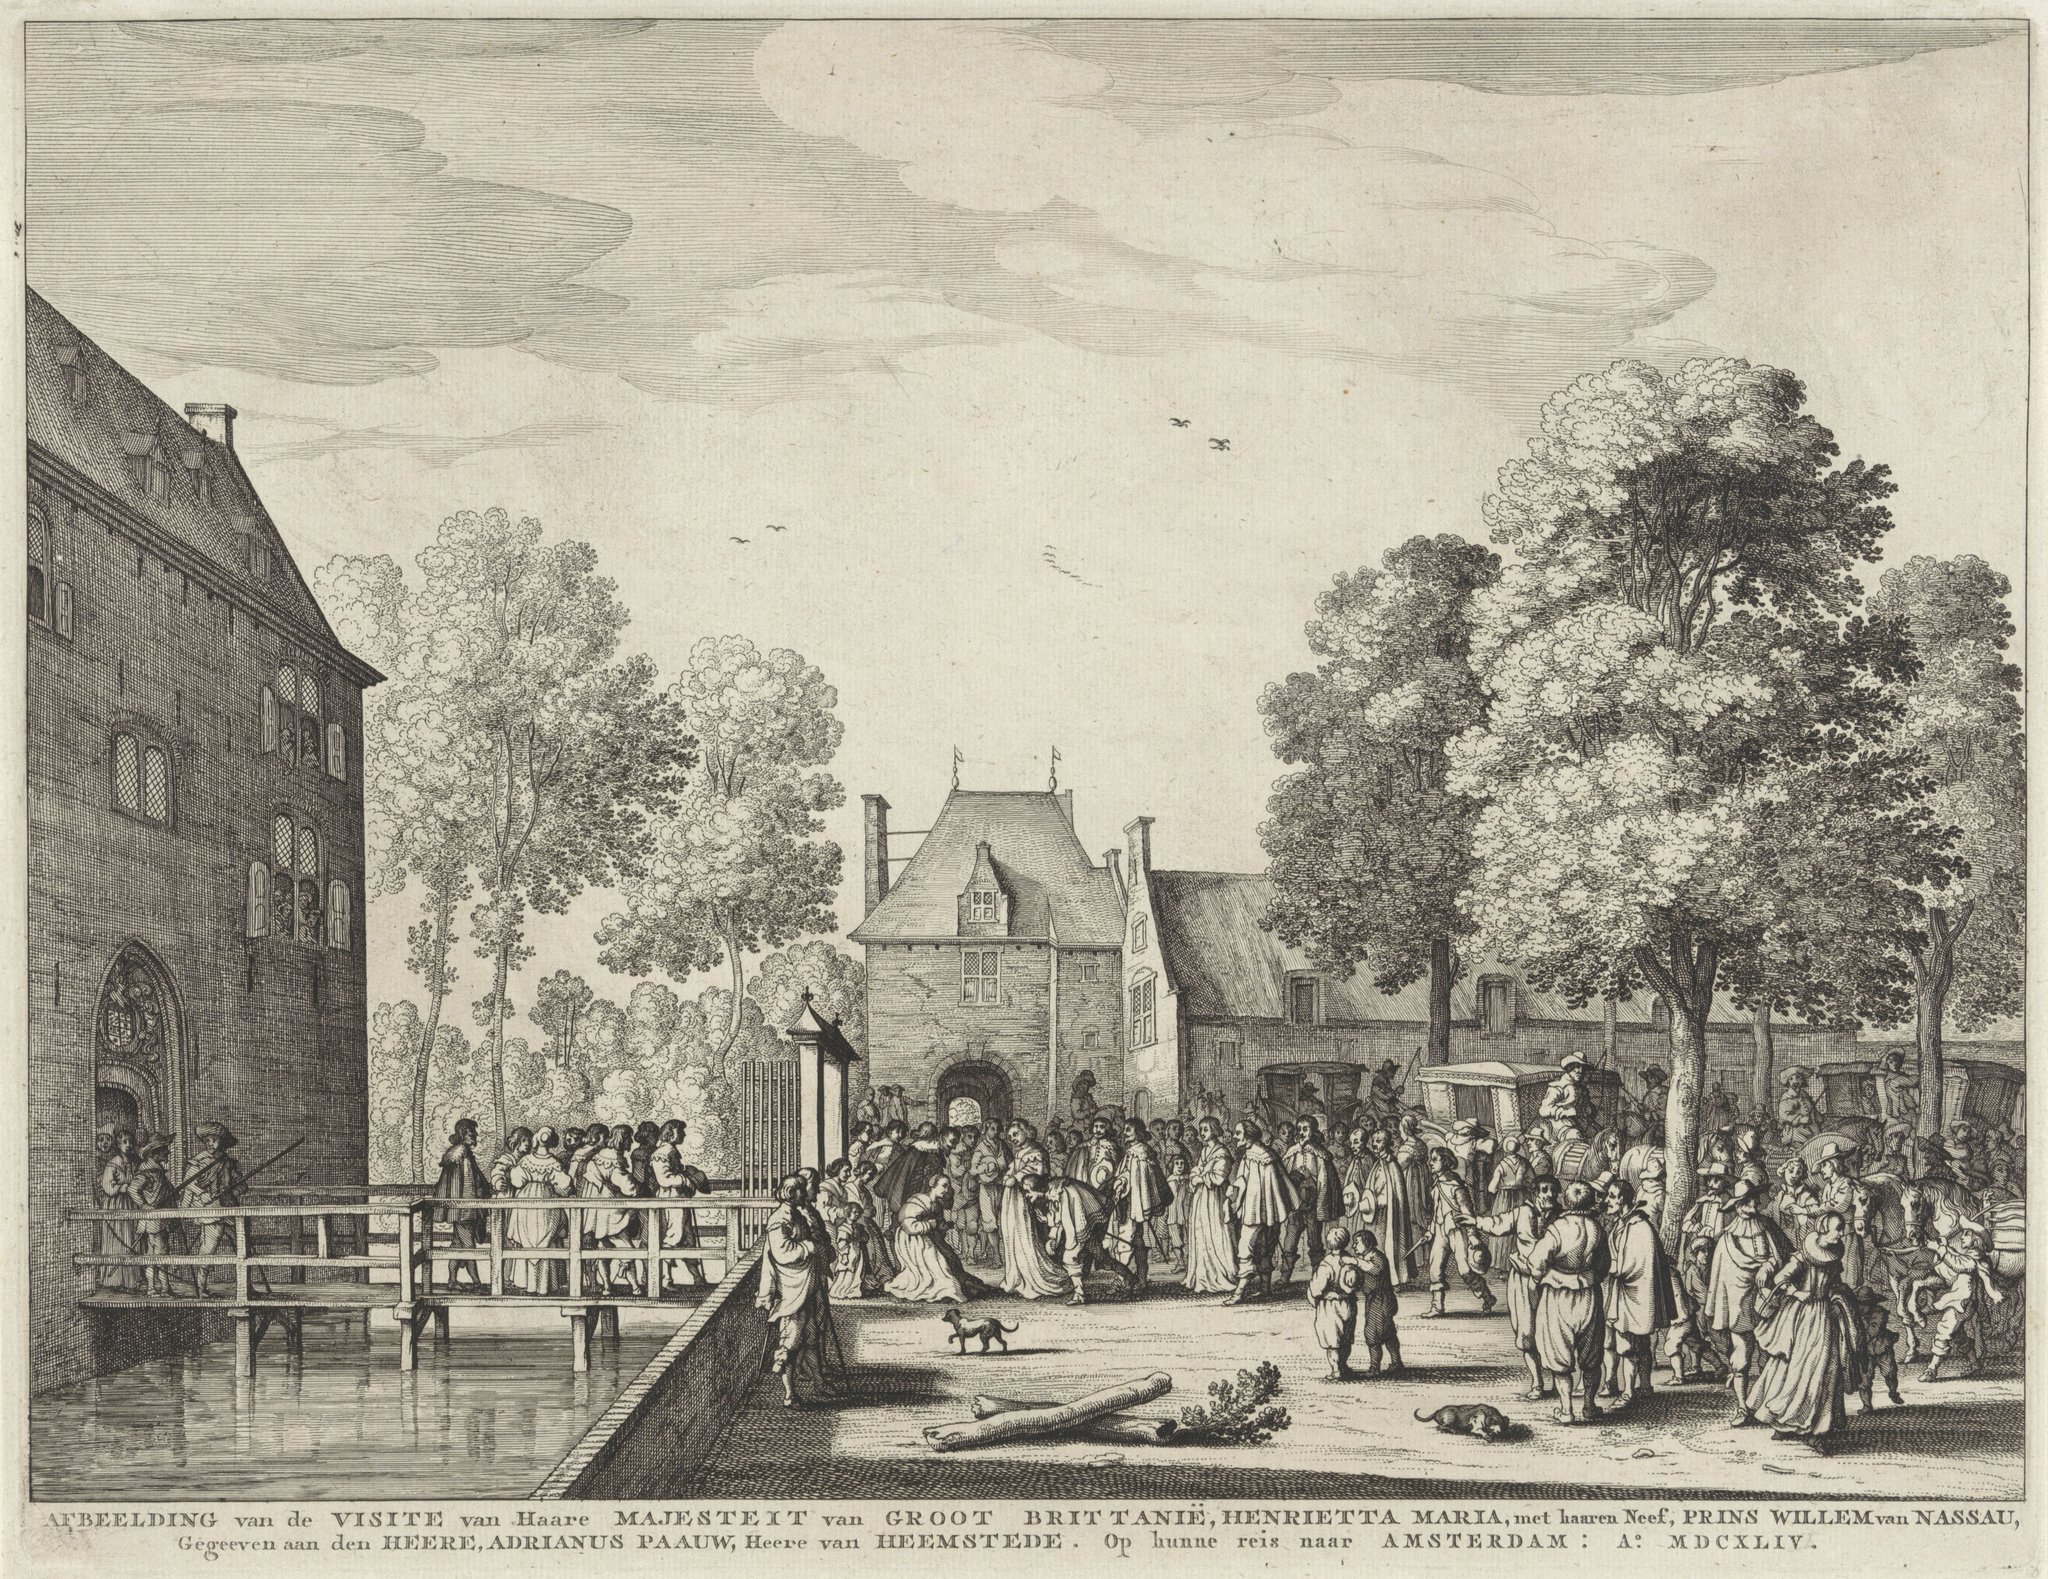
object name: print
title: Bezoek van koningin Henrietta Maria aan Adriaen Pauw op het Slot te Heemstede, 1642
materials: paper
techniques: etching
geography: northern netherlands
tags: henriëtta maria van frankrijk (koningin van engeland, schotland en ierland), william ii (prince of orange), amsterdam, the hague, adriaen pauw (1585-1653), castle, visiting; receiving guests; elegant company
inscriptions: collector's mark: Lugt 2228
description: Een gesigneerde tekening door Jan Martszen de Jonge in spiegelbeeld in particuliere verzameling te Den Haag (in 1977) is mogelijk de ontwerptekening voor deze prent. In de titel op het object staat onterecht het jaartal 1644. Zie ook RP-P-AO-9-39-1, RP-P-AO-9-39-2, RP-P-1894-A-18283, RP-P-1944-2138, RP-P-OB-81.518, RP-P-OB-81.519 en RP-P-OB-2510.